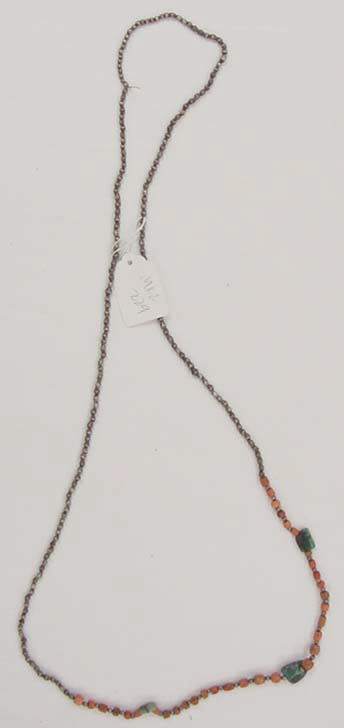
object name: necklace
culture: tibetan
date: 1801-1900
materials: coral, metal